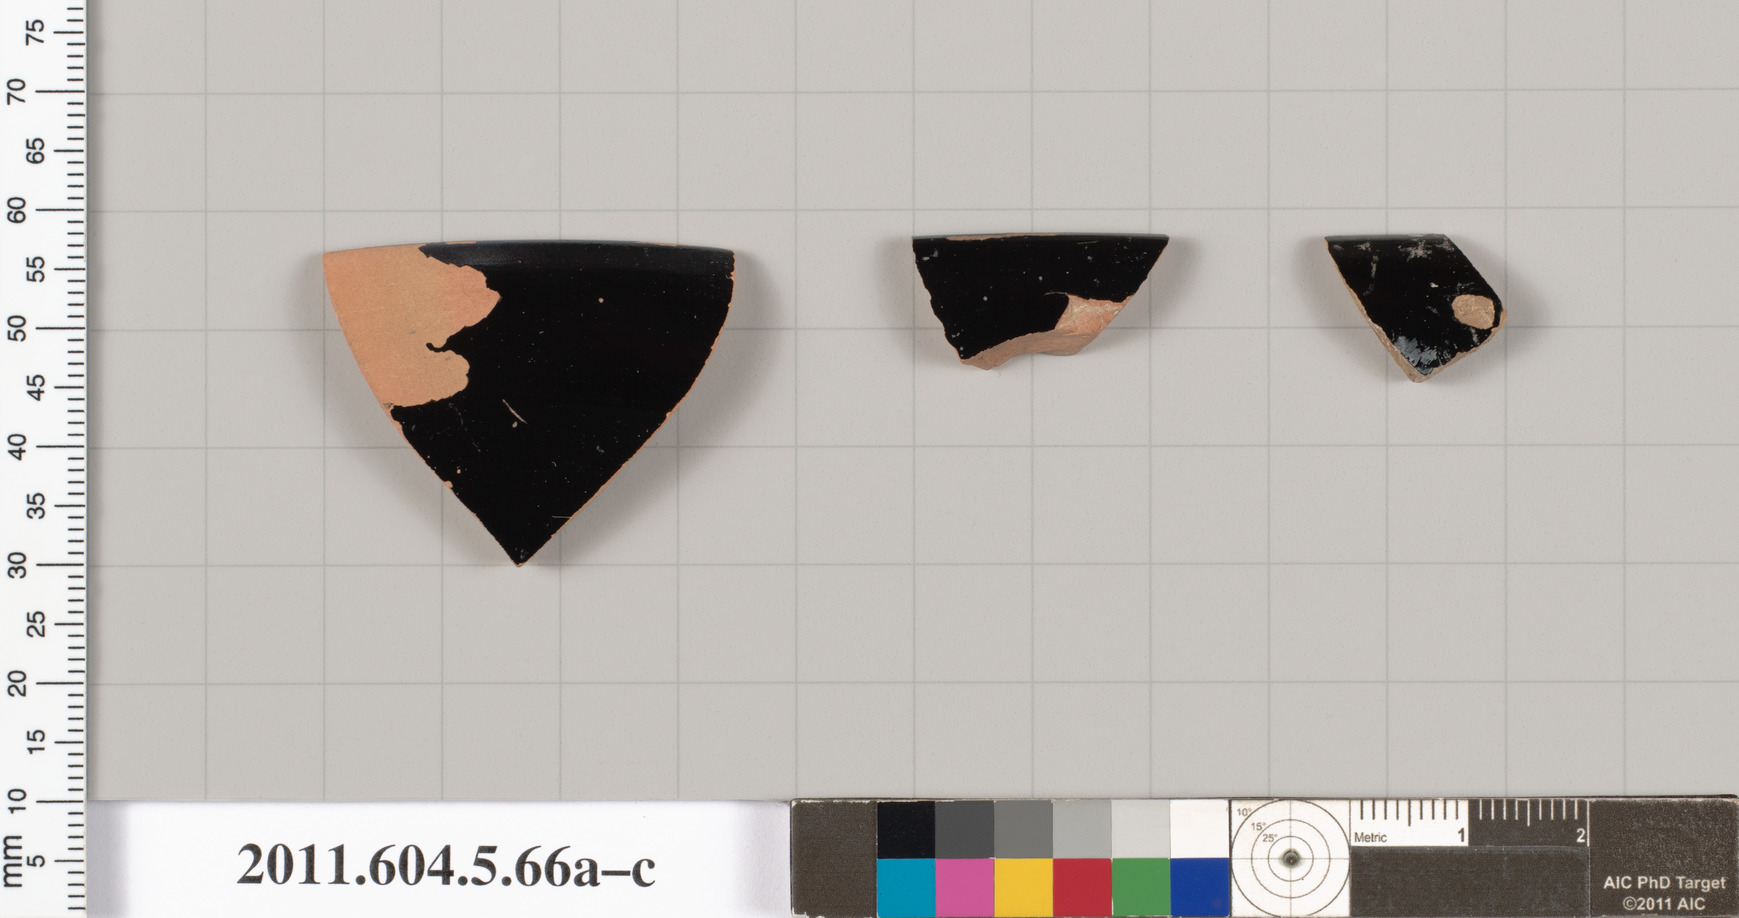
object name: kylix fragment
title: Terracotta rim fragments of kylikes (drinking cups)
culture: greek, attic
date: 500-476 BCE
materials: terracotta